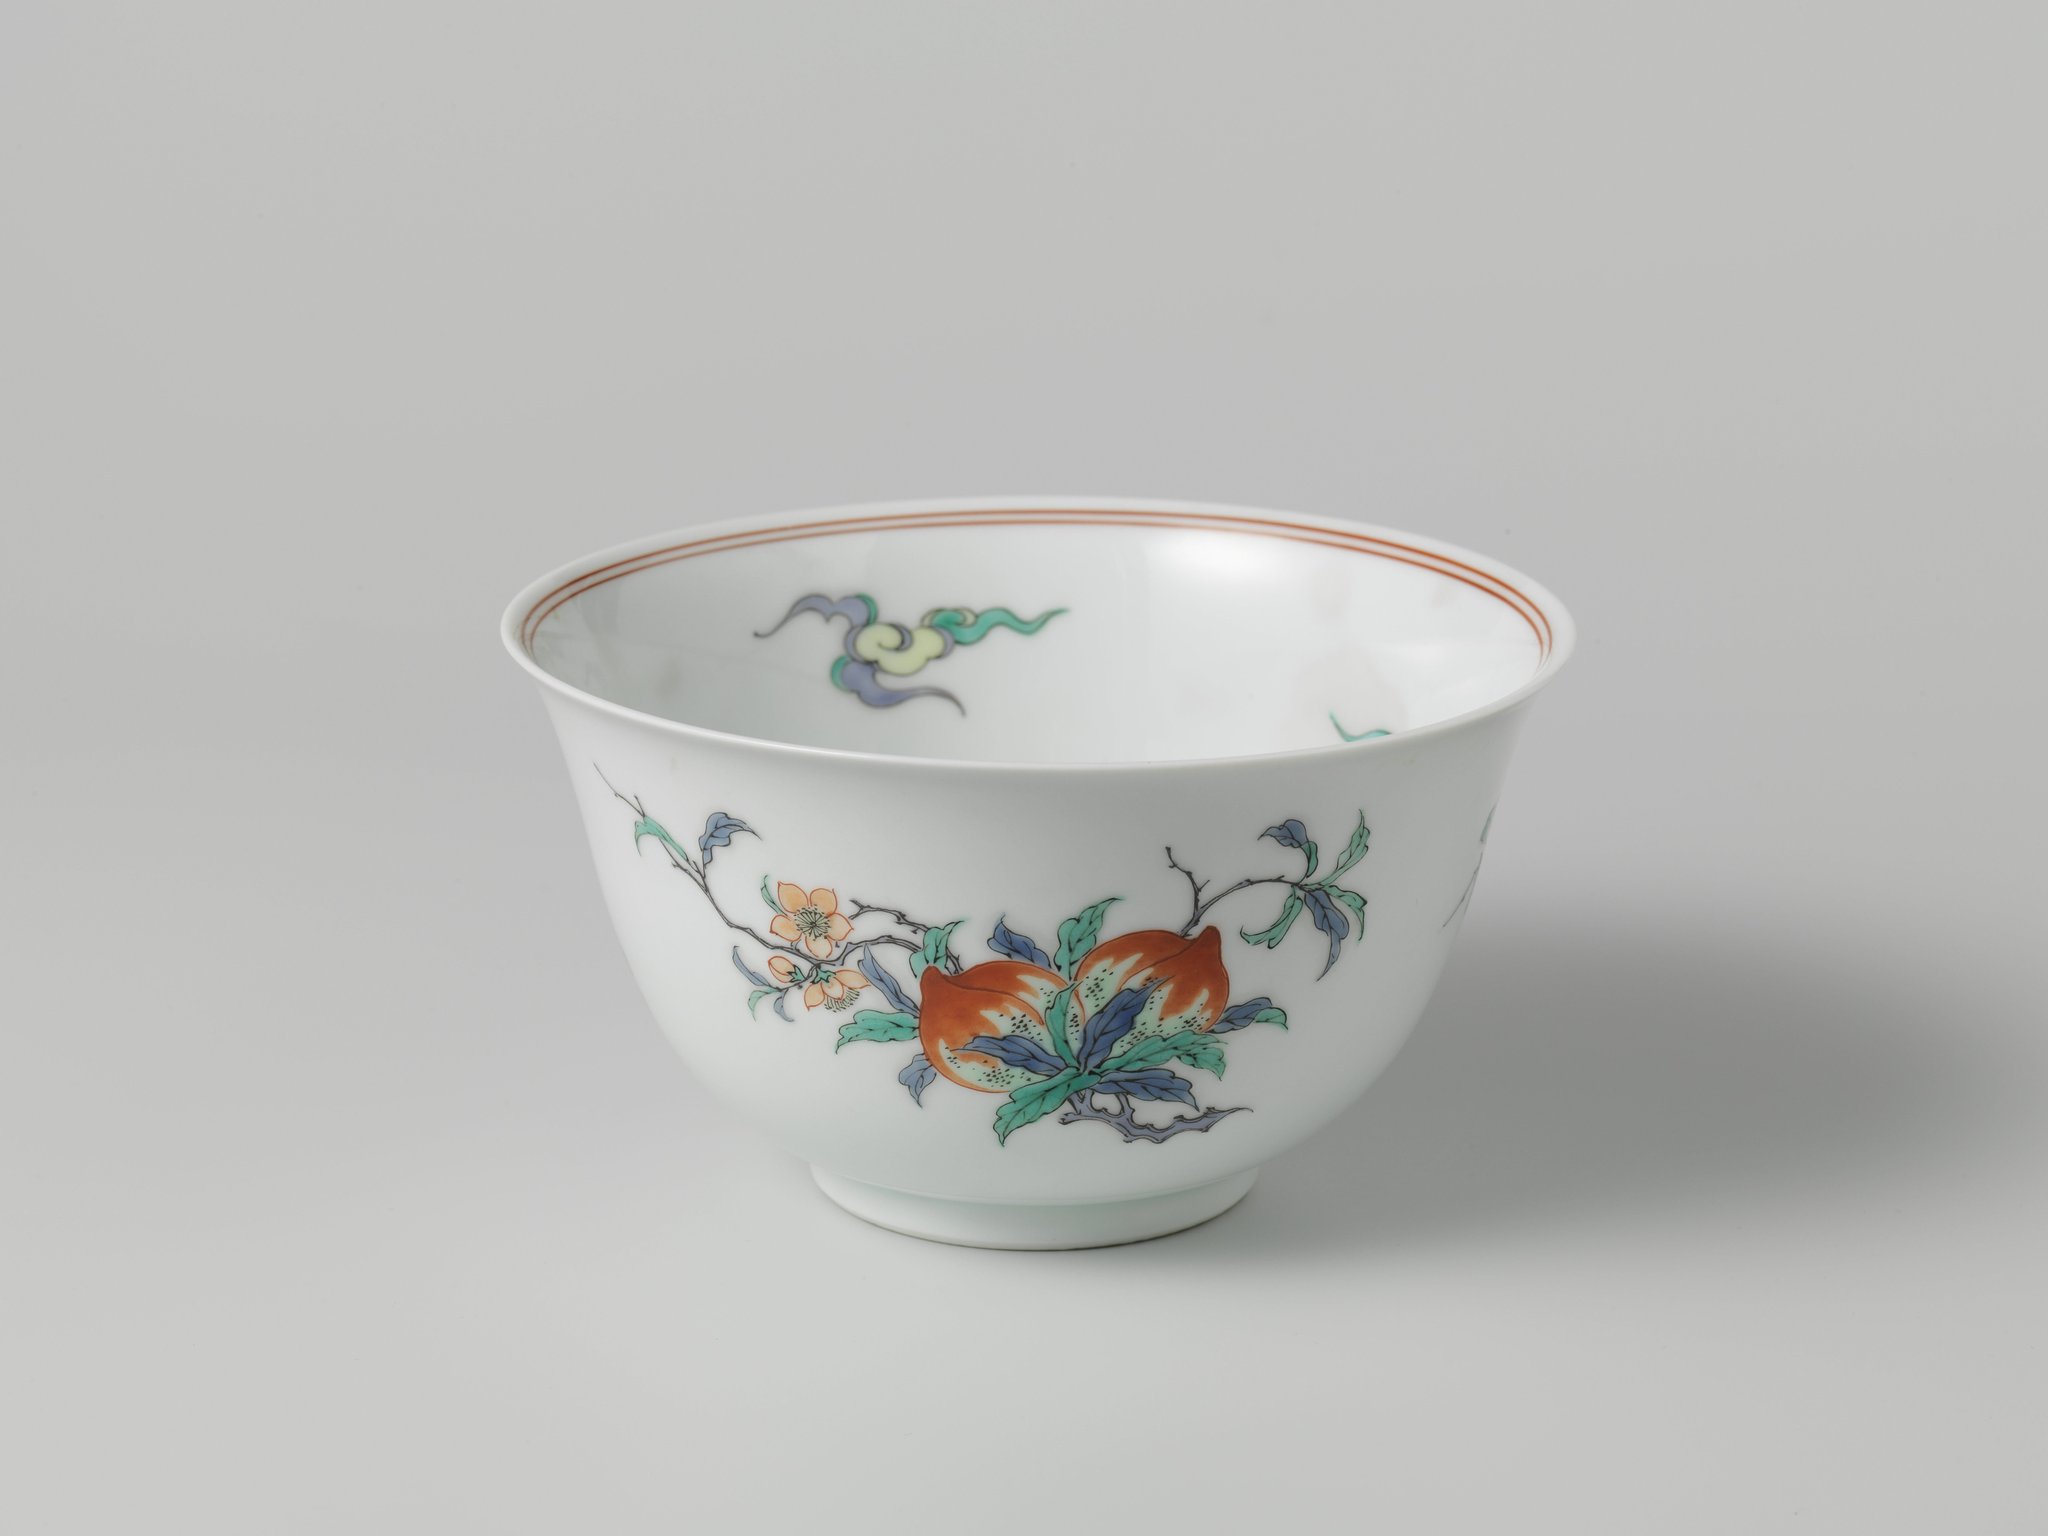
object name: bowl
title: Bell-shaped bowl with fruit sprays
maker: Anonymous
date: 1800-1899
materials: cobalt, glaze, paint, porcelain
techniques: firing, turning, vitrification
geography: kyoto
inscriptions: mark: ‘heian hokuhô’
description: Klokvormige kom van porselein, beschilderd in onderglazuur blauw en op het glazuur blauw, rood, groen, geel en zwart. De buitenwand van de kom met drie fruittakken (granaatappel, perzik, vingercitroen). Op de bodem een karakter in een dubbel medaillon. De binnenwand met wolk- en vlammotieven. Gemerkt op de onderzijde met vier karakters 'heian hokuhô'. Kyoyaki.